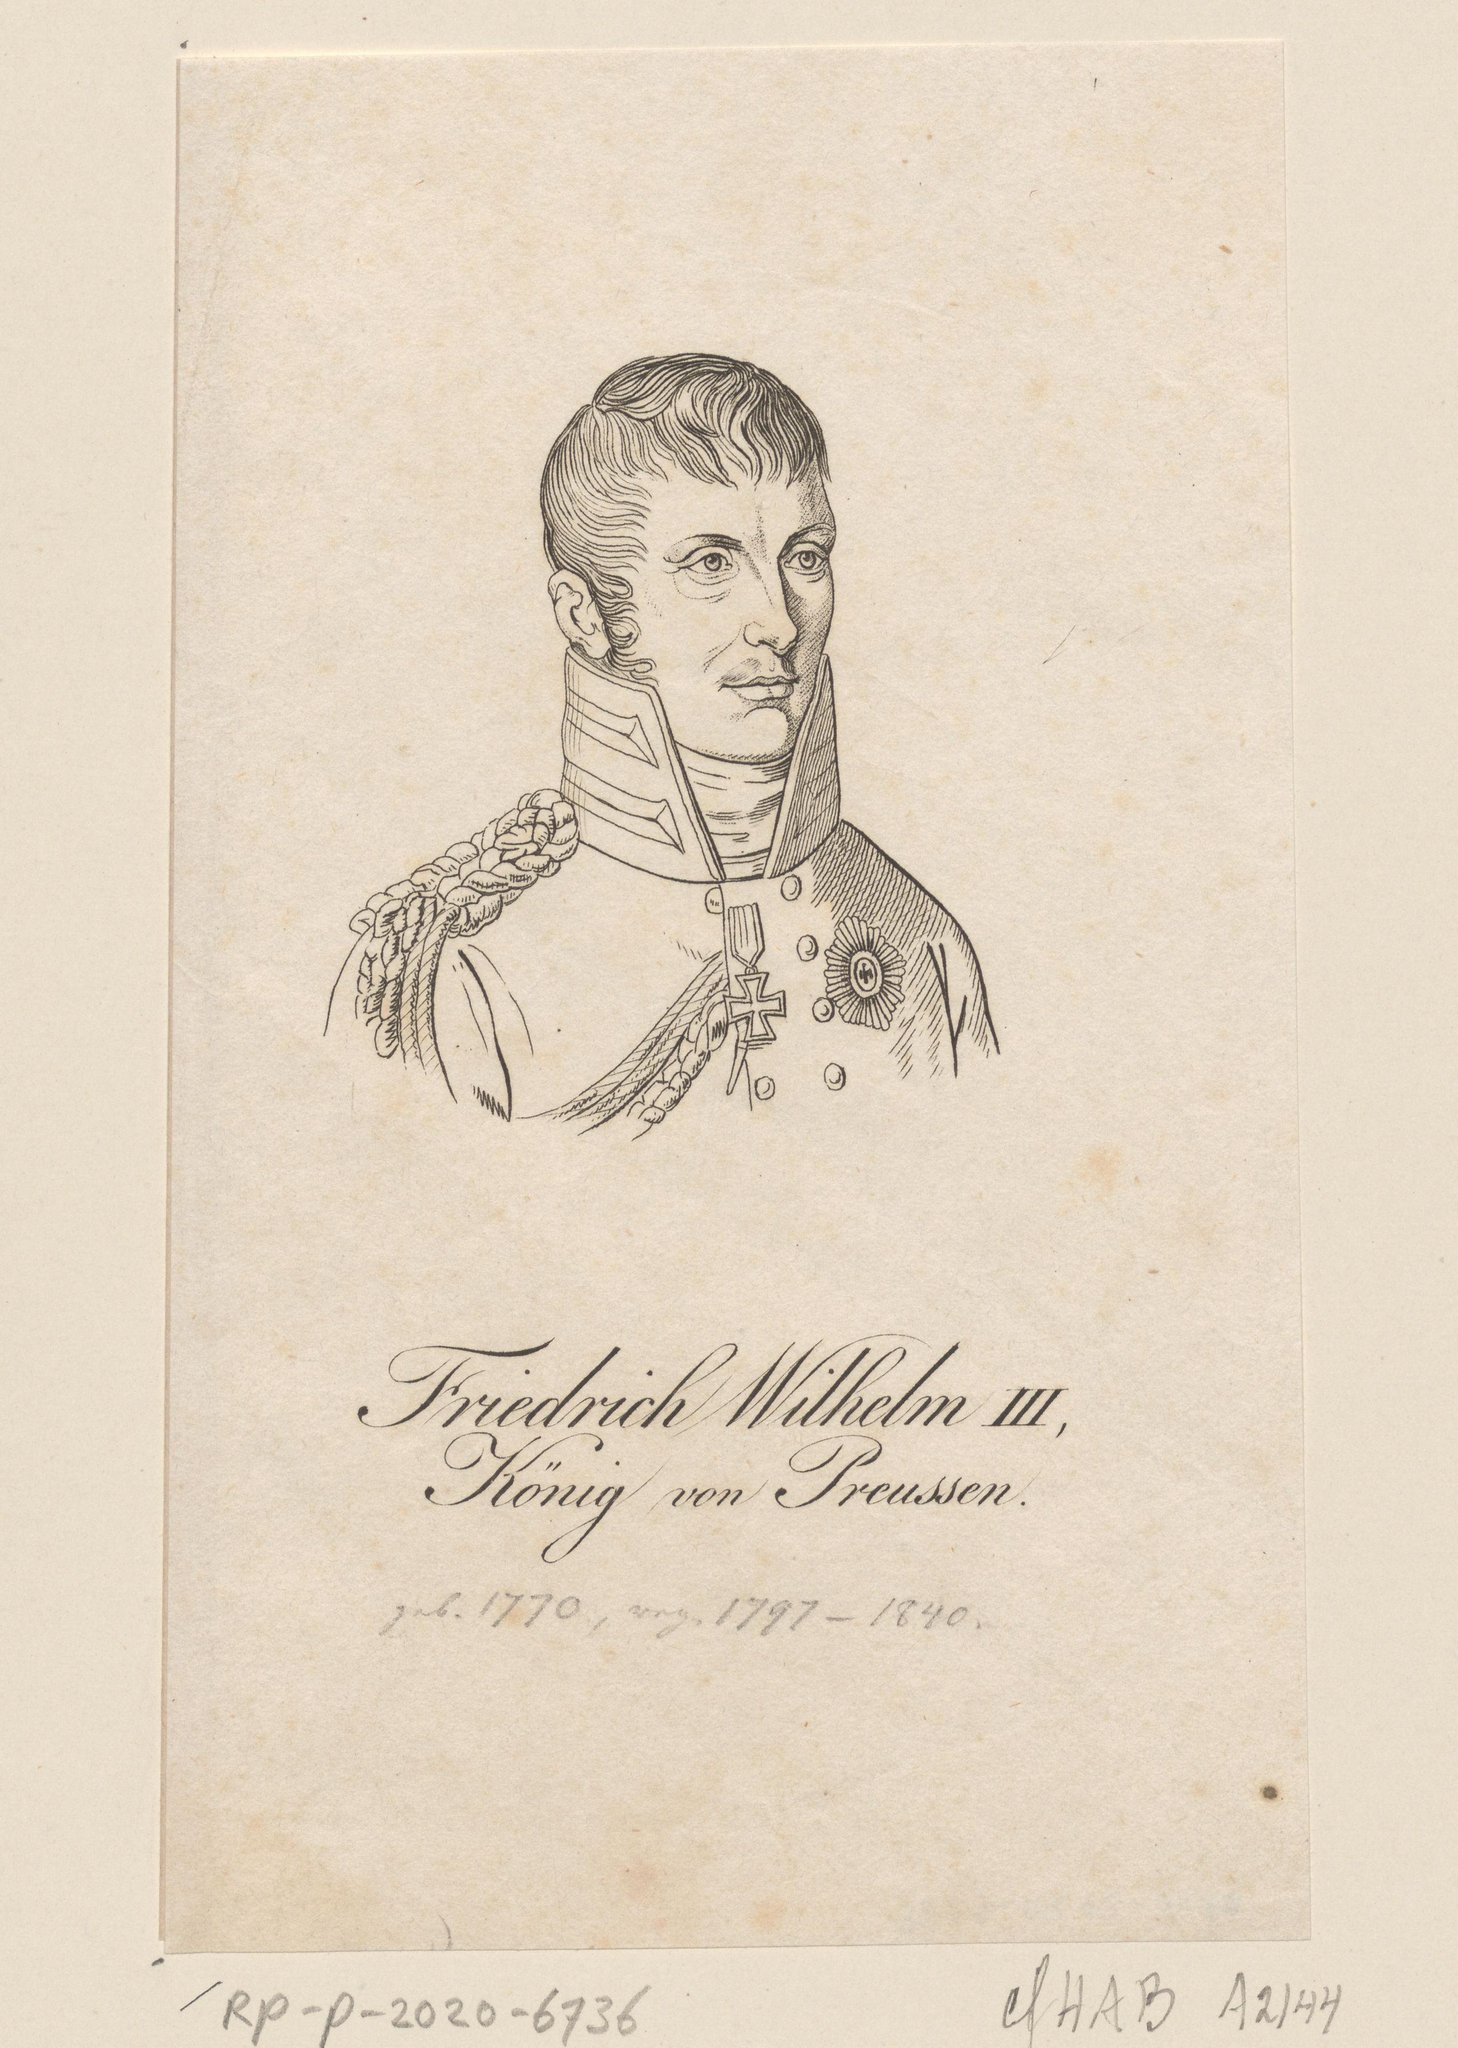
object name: print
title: Portret van Frederik Willem III van Pruisen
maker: Anonymous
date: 1797-1850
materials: paper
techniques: etching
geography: germany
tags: berlin, frederik willem iii koning van pruisen, historical persons, (military) uniforms, king